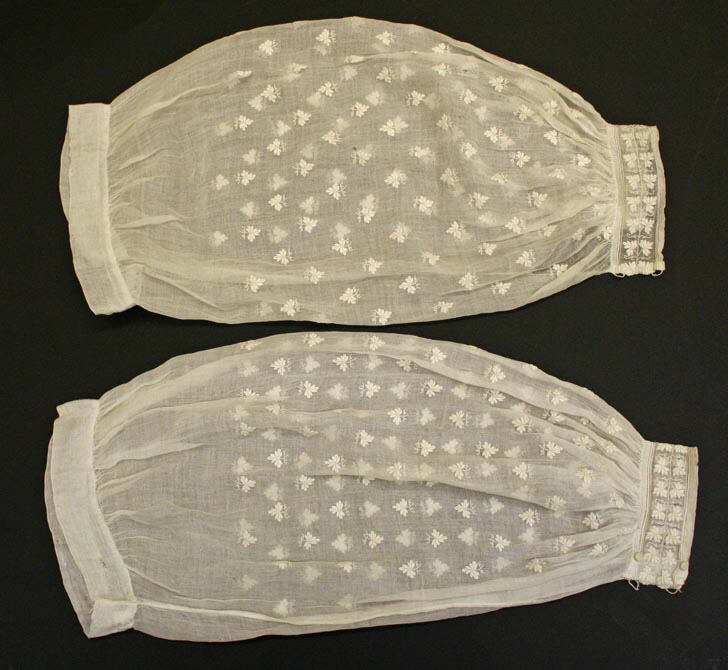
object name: undersleeves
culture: british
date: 1865-1868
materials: cotton